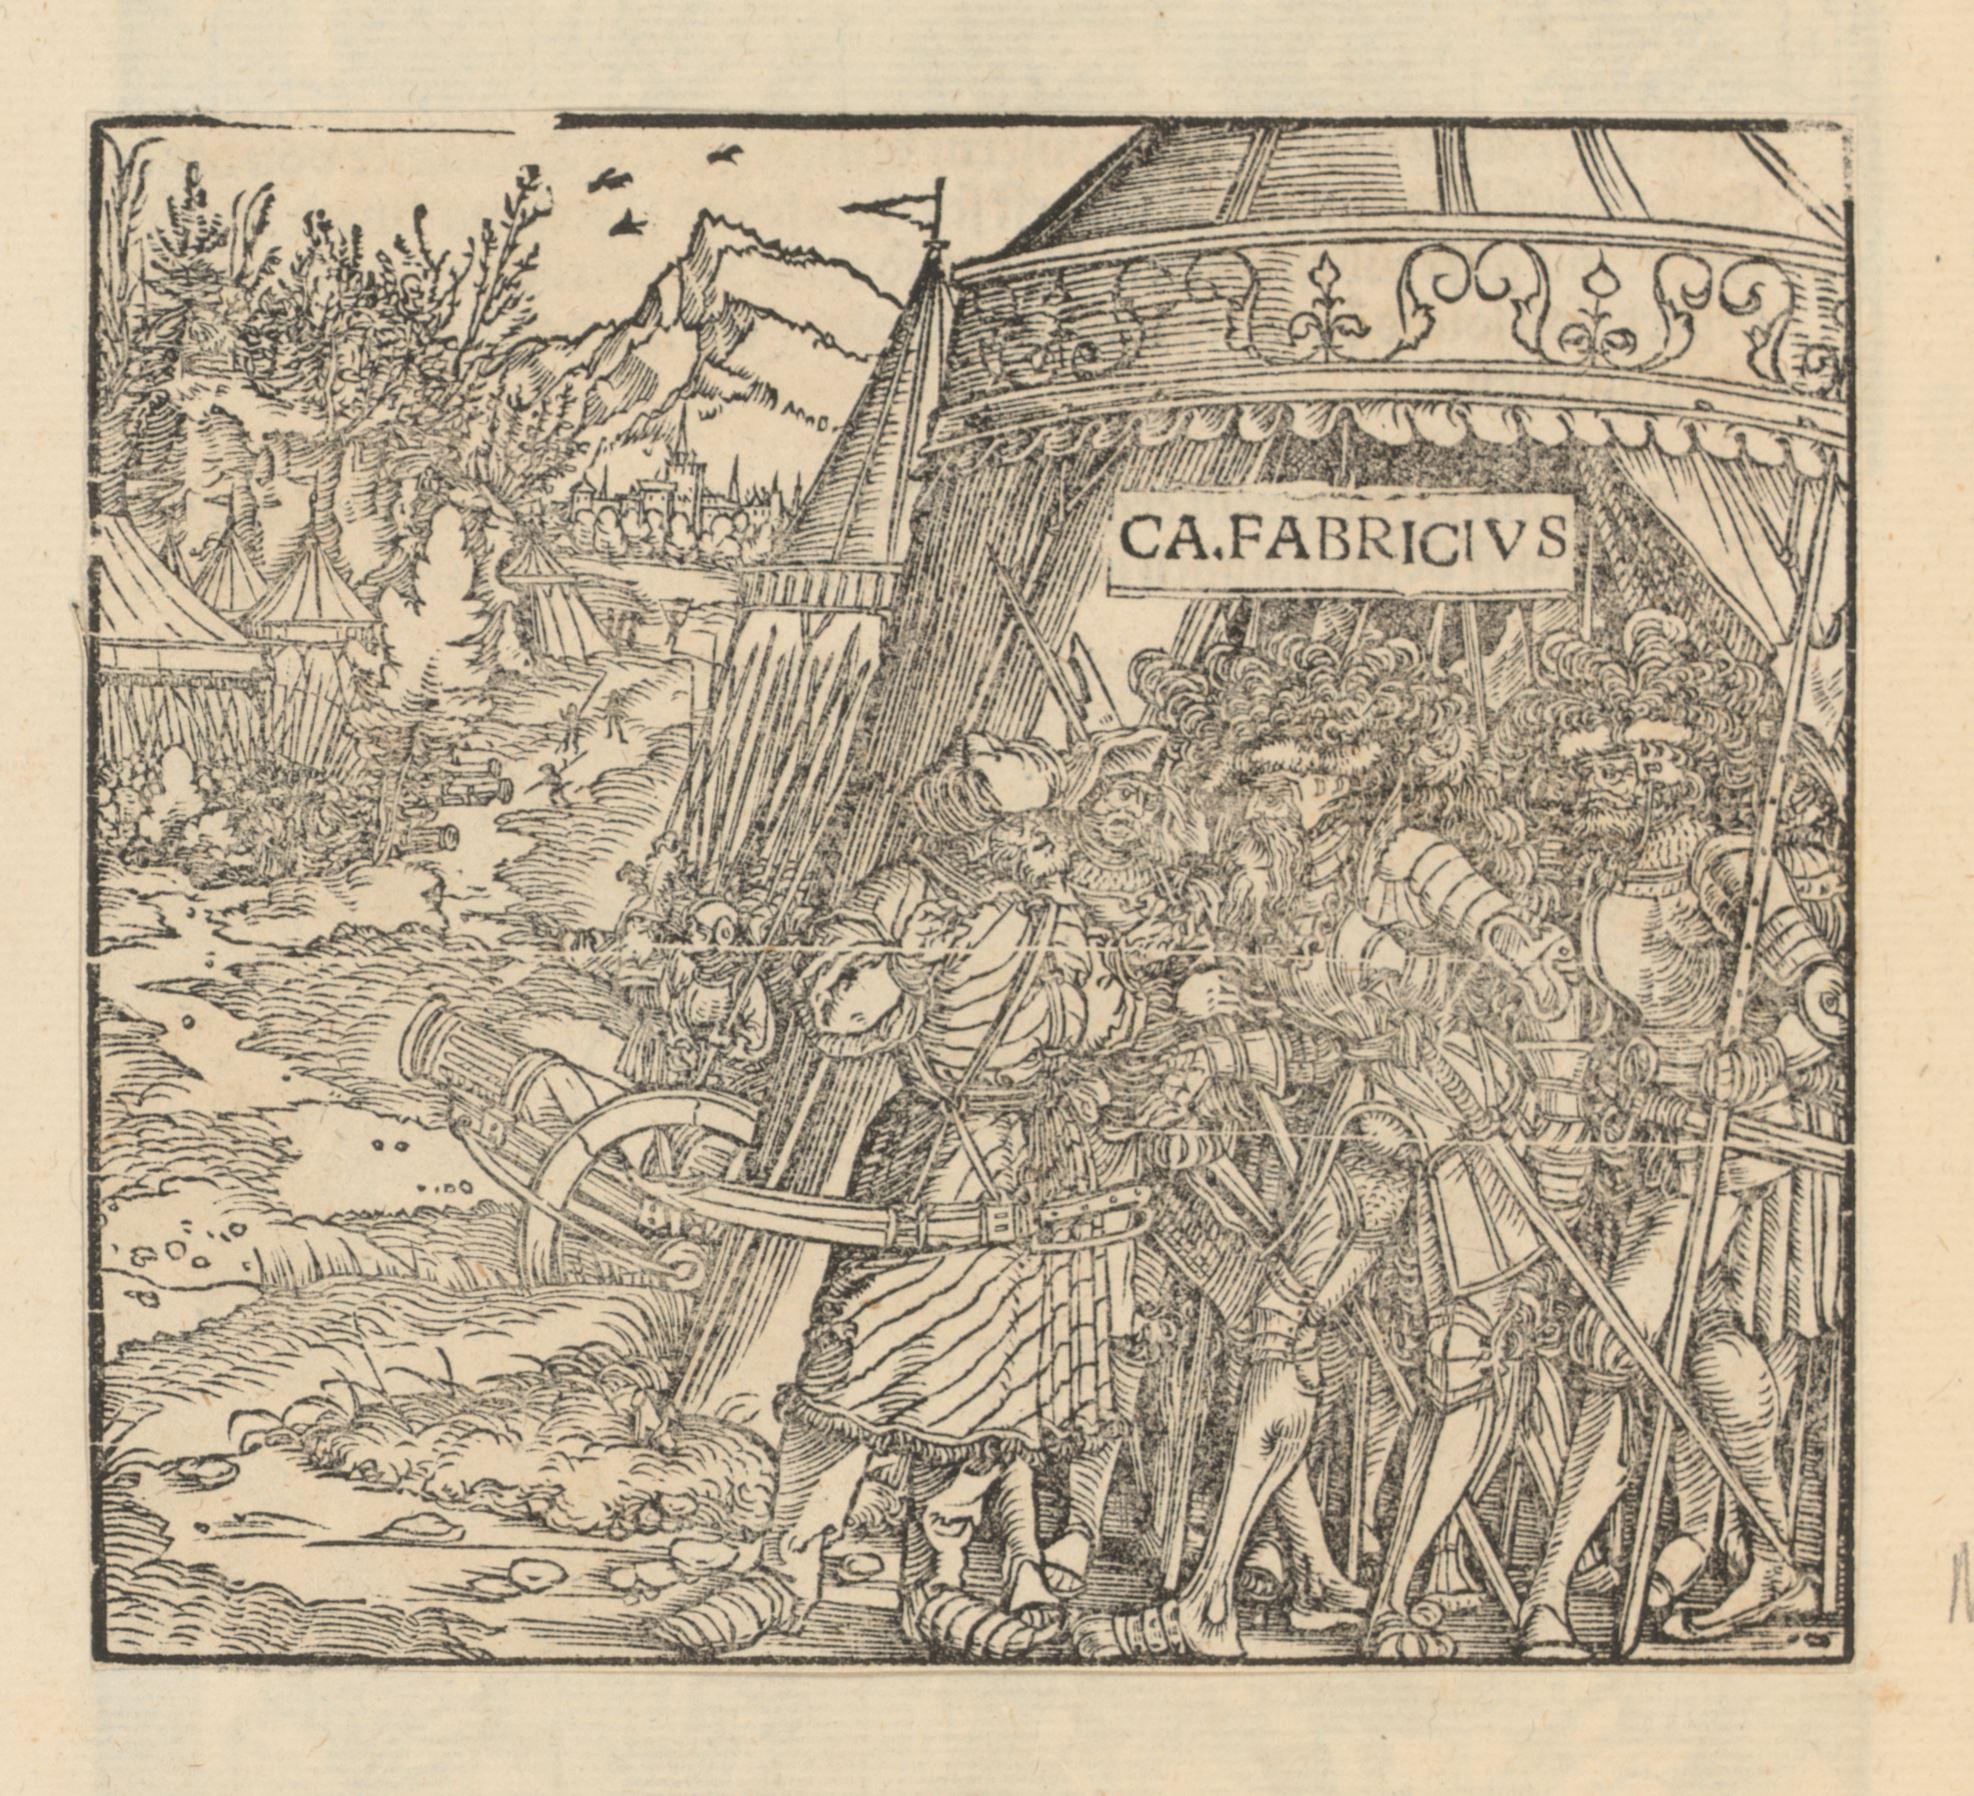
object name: print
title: Gaius Fabricius verwerpt de suggestie van een boodschapper van Pyrrhus bij zijn legertent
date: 1514-1531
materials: paper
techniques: letterpress printing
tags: peace negotiations, address by general before the battle, good government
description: Deze prent is gebruikt in: Cicero, Marcus Tulius. Officia M.T.C. Ein Buch so Marcus Tullius Cicero der Römer zu seynem (...). [Vertaald uit het Latijn door] Johann von Schwarzenberg. Augsburg: Heinrich Steiner, 1531.